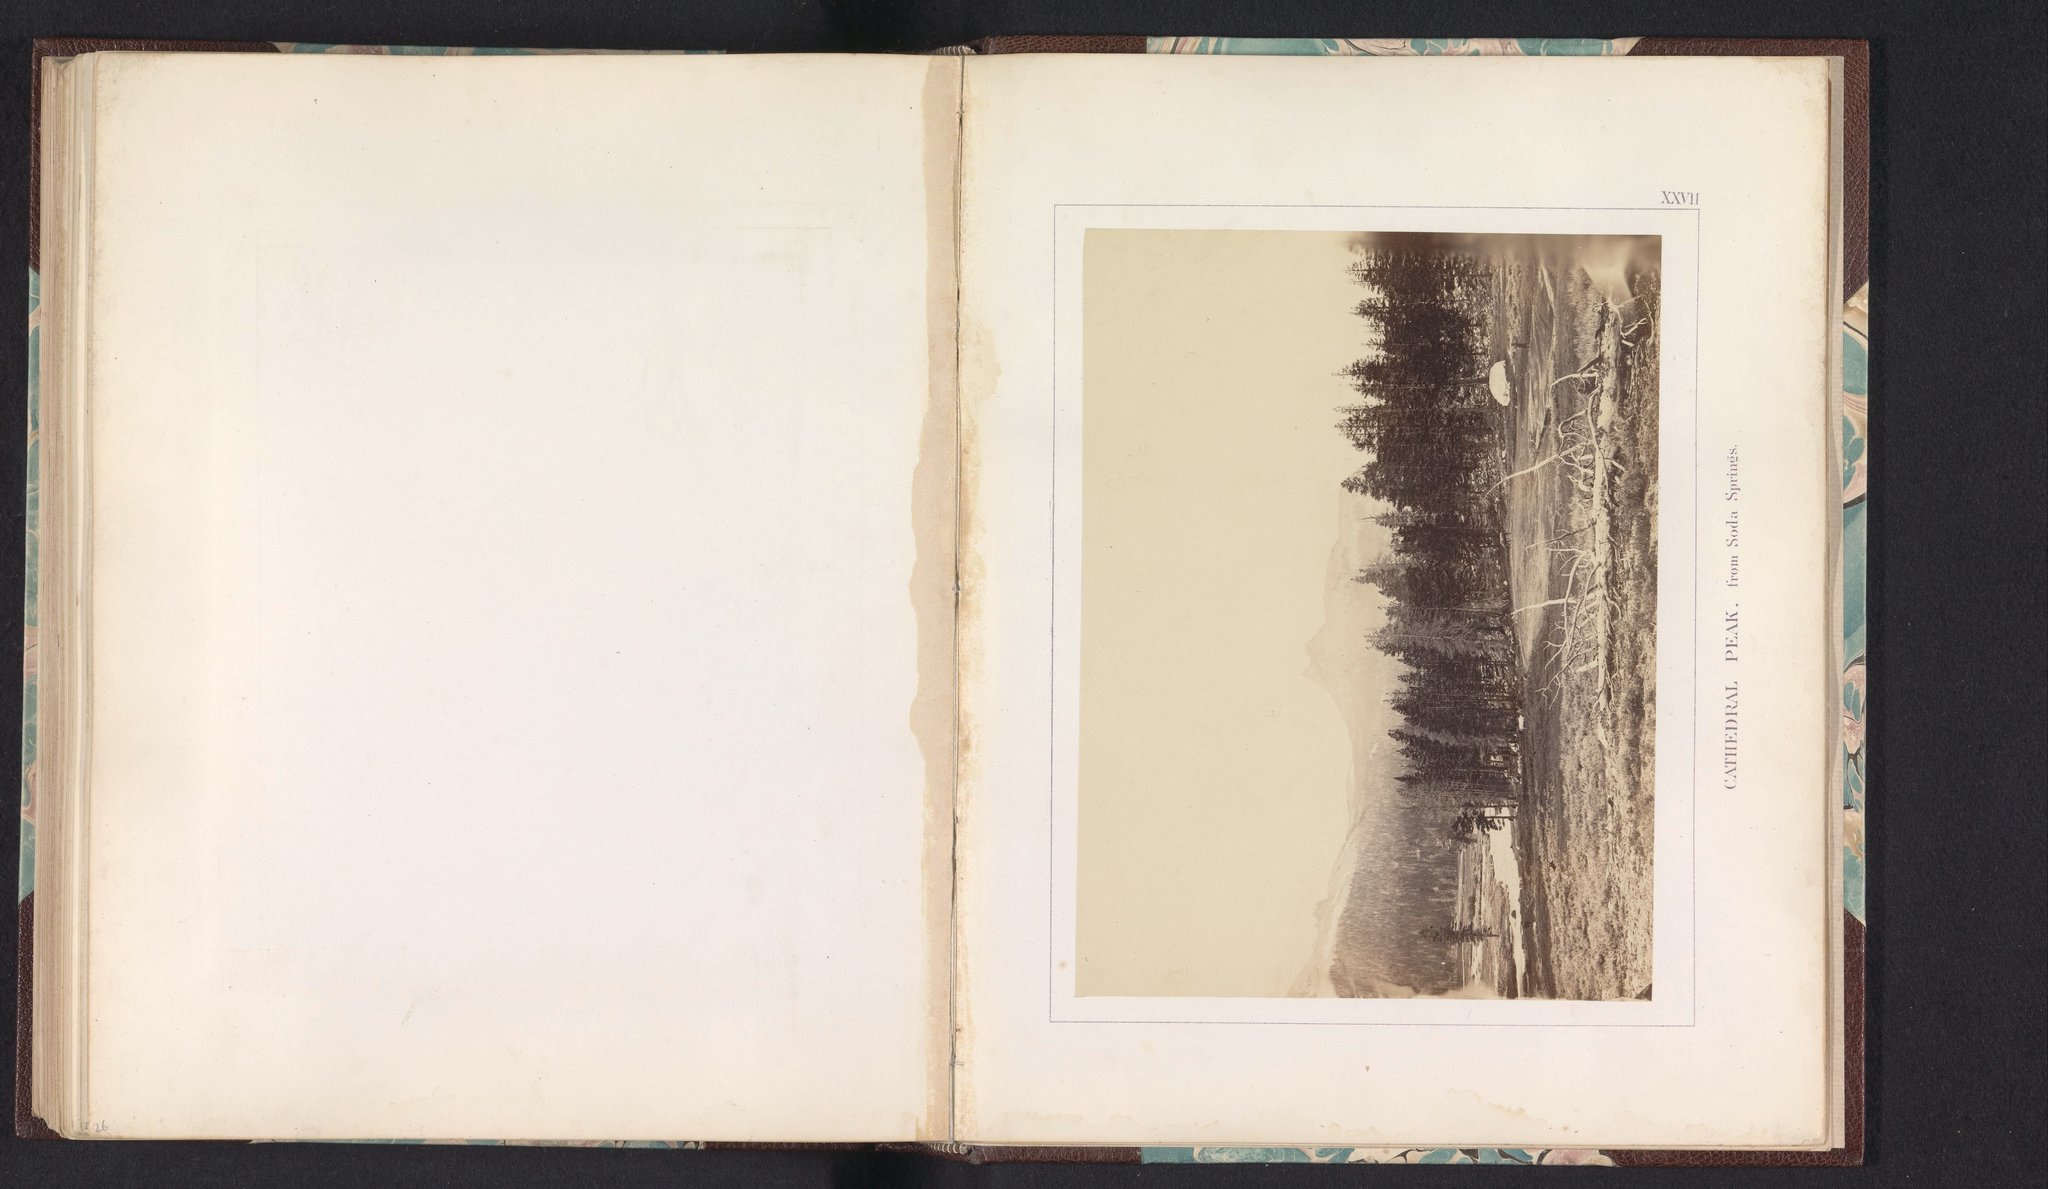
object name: page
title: Gezicht op Cathedral Peak in Californië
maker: w. harris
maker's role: fotograaf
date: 1860-1868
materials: photographic support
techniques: albumen print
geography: california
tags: mountains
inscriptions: number: ‘XXVII.’